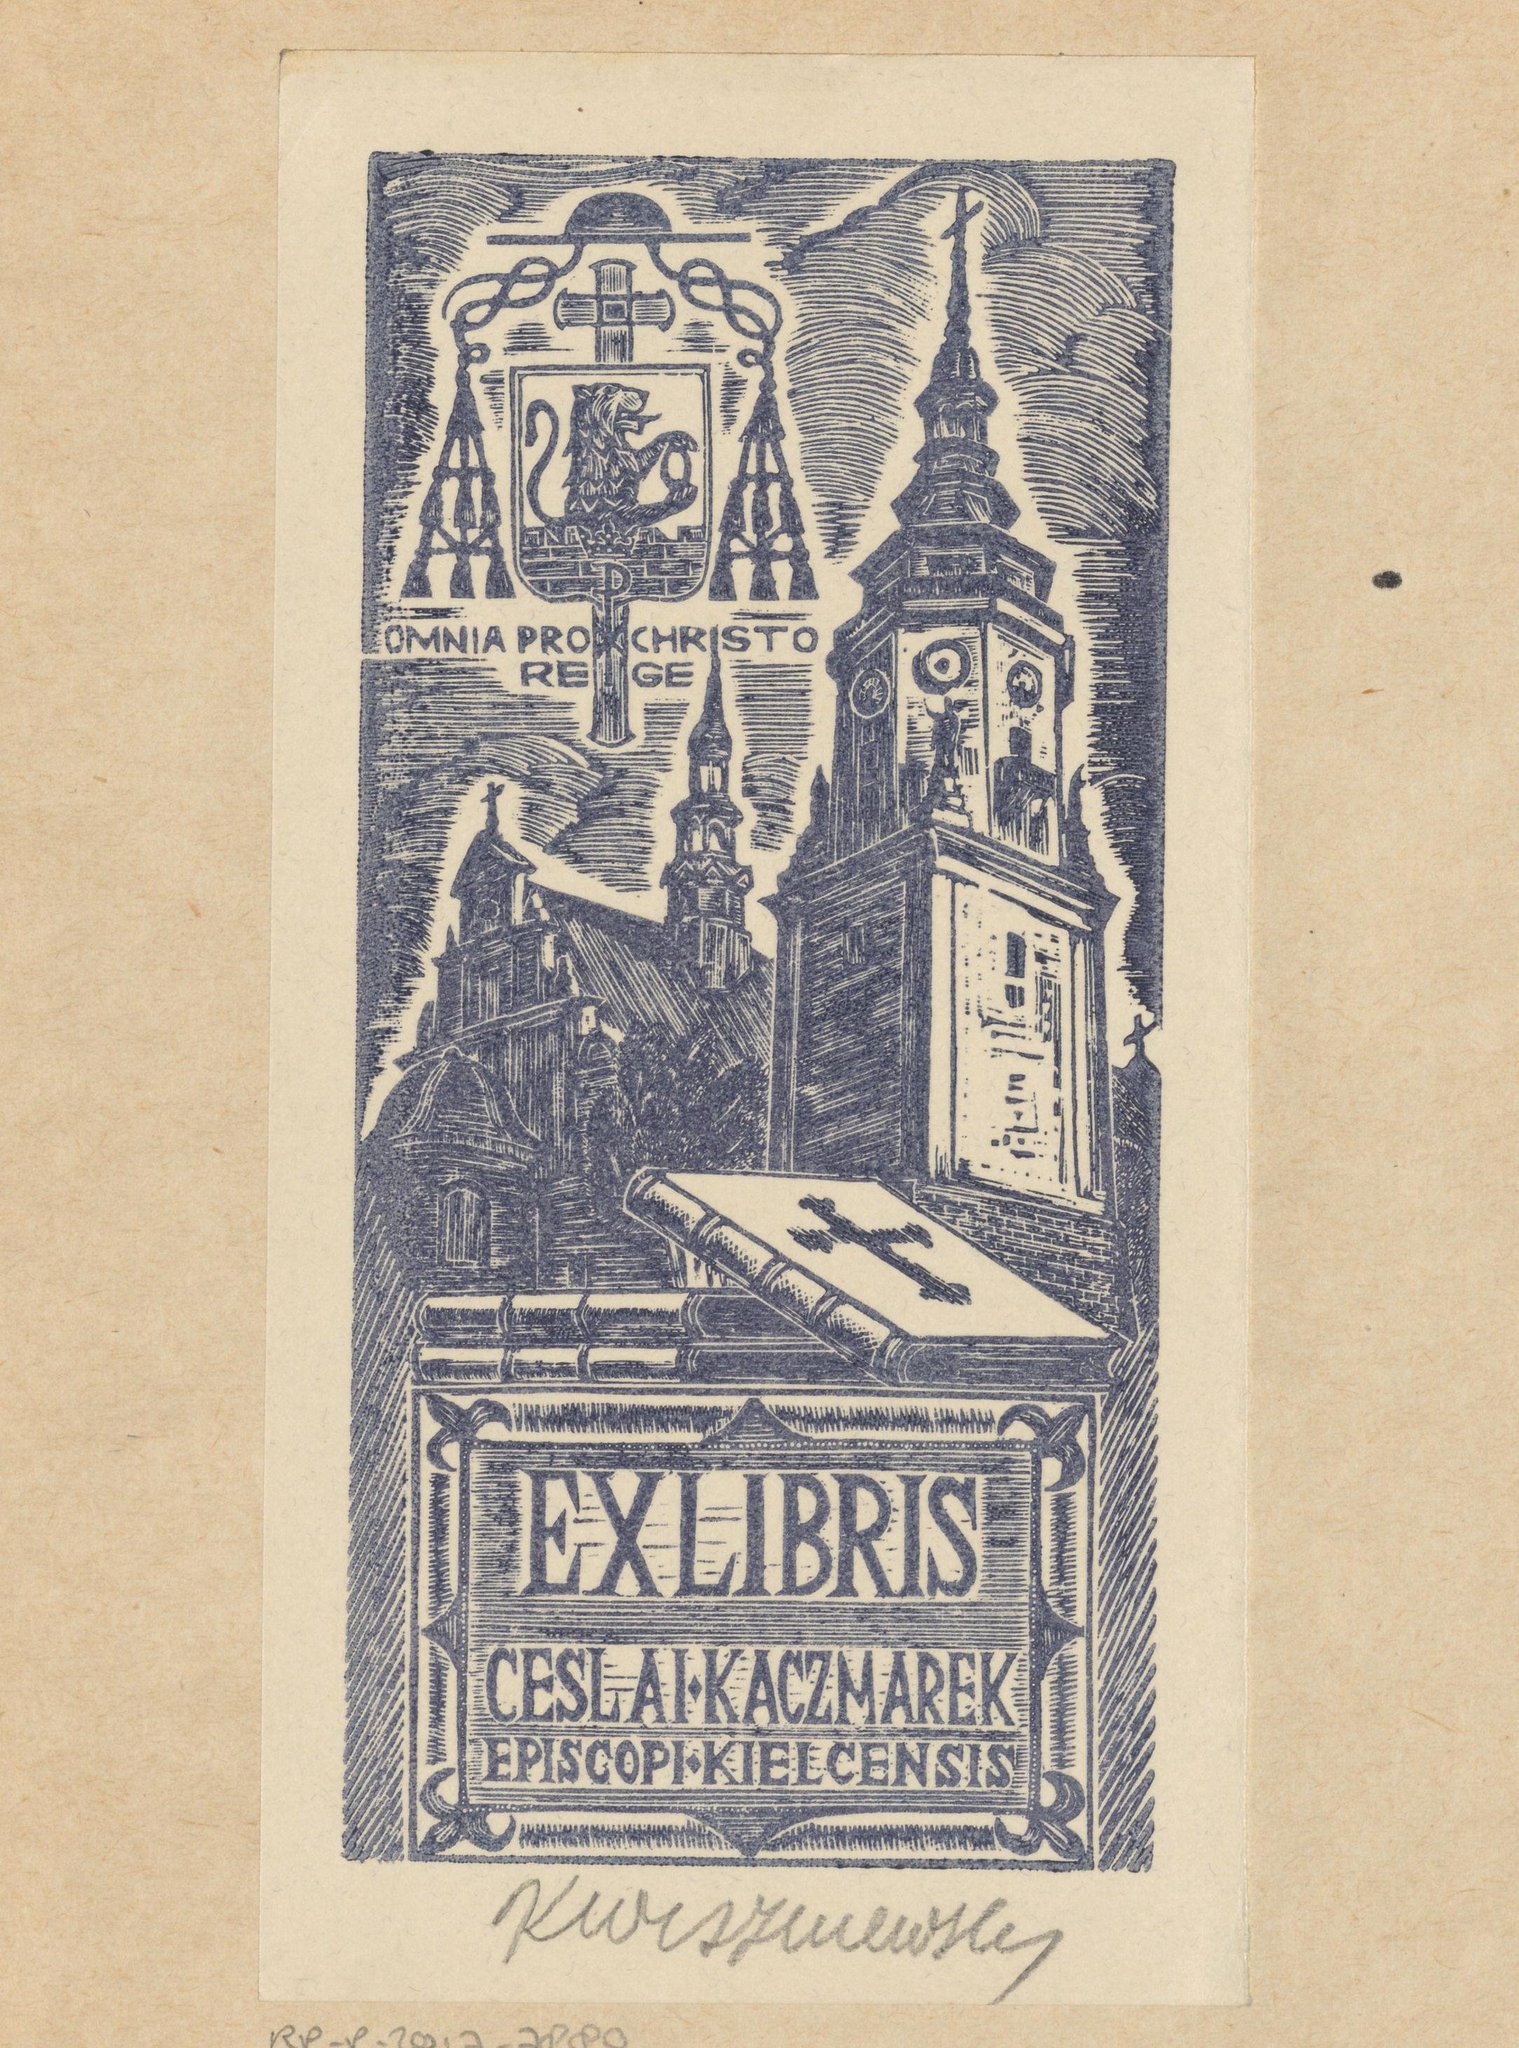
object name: bookplate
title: Ex libris/ Ceslai Kaczmarek/ Episcopi Kielcensis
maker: Anonymous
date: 1905-1963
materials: paper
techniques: woodcut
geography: poland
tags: church (exterior), book, armorial bearing, heraldry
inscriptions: signature